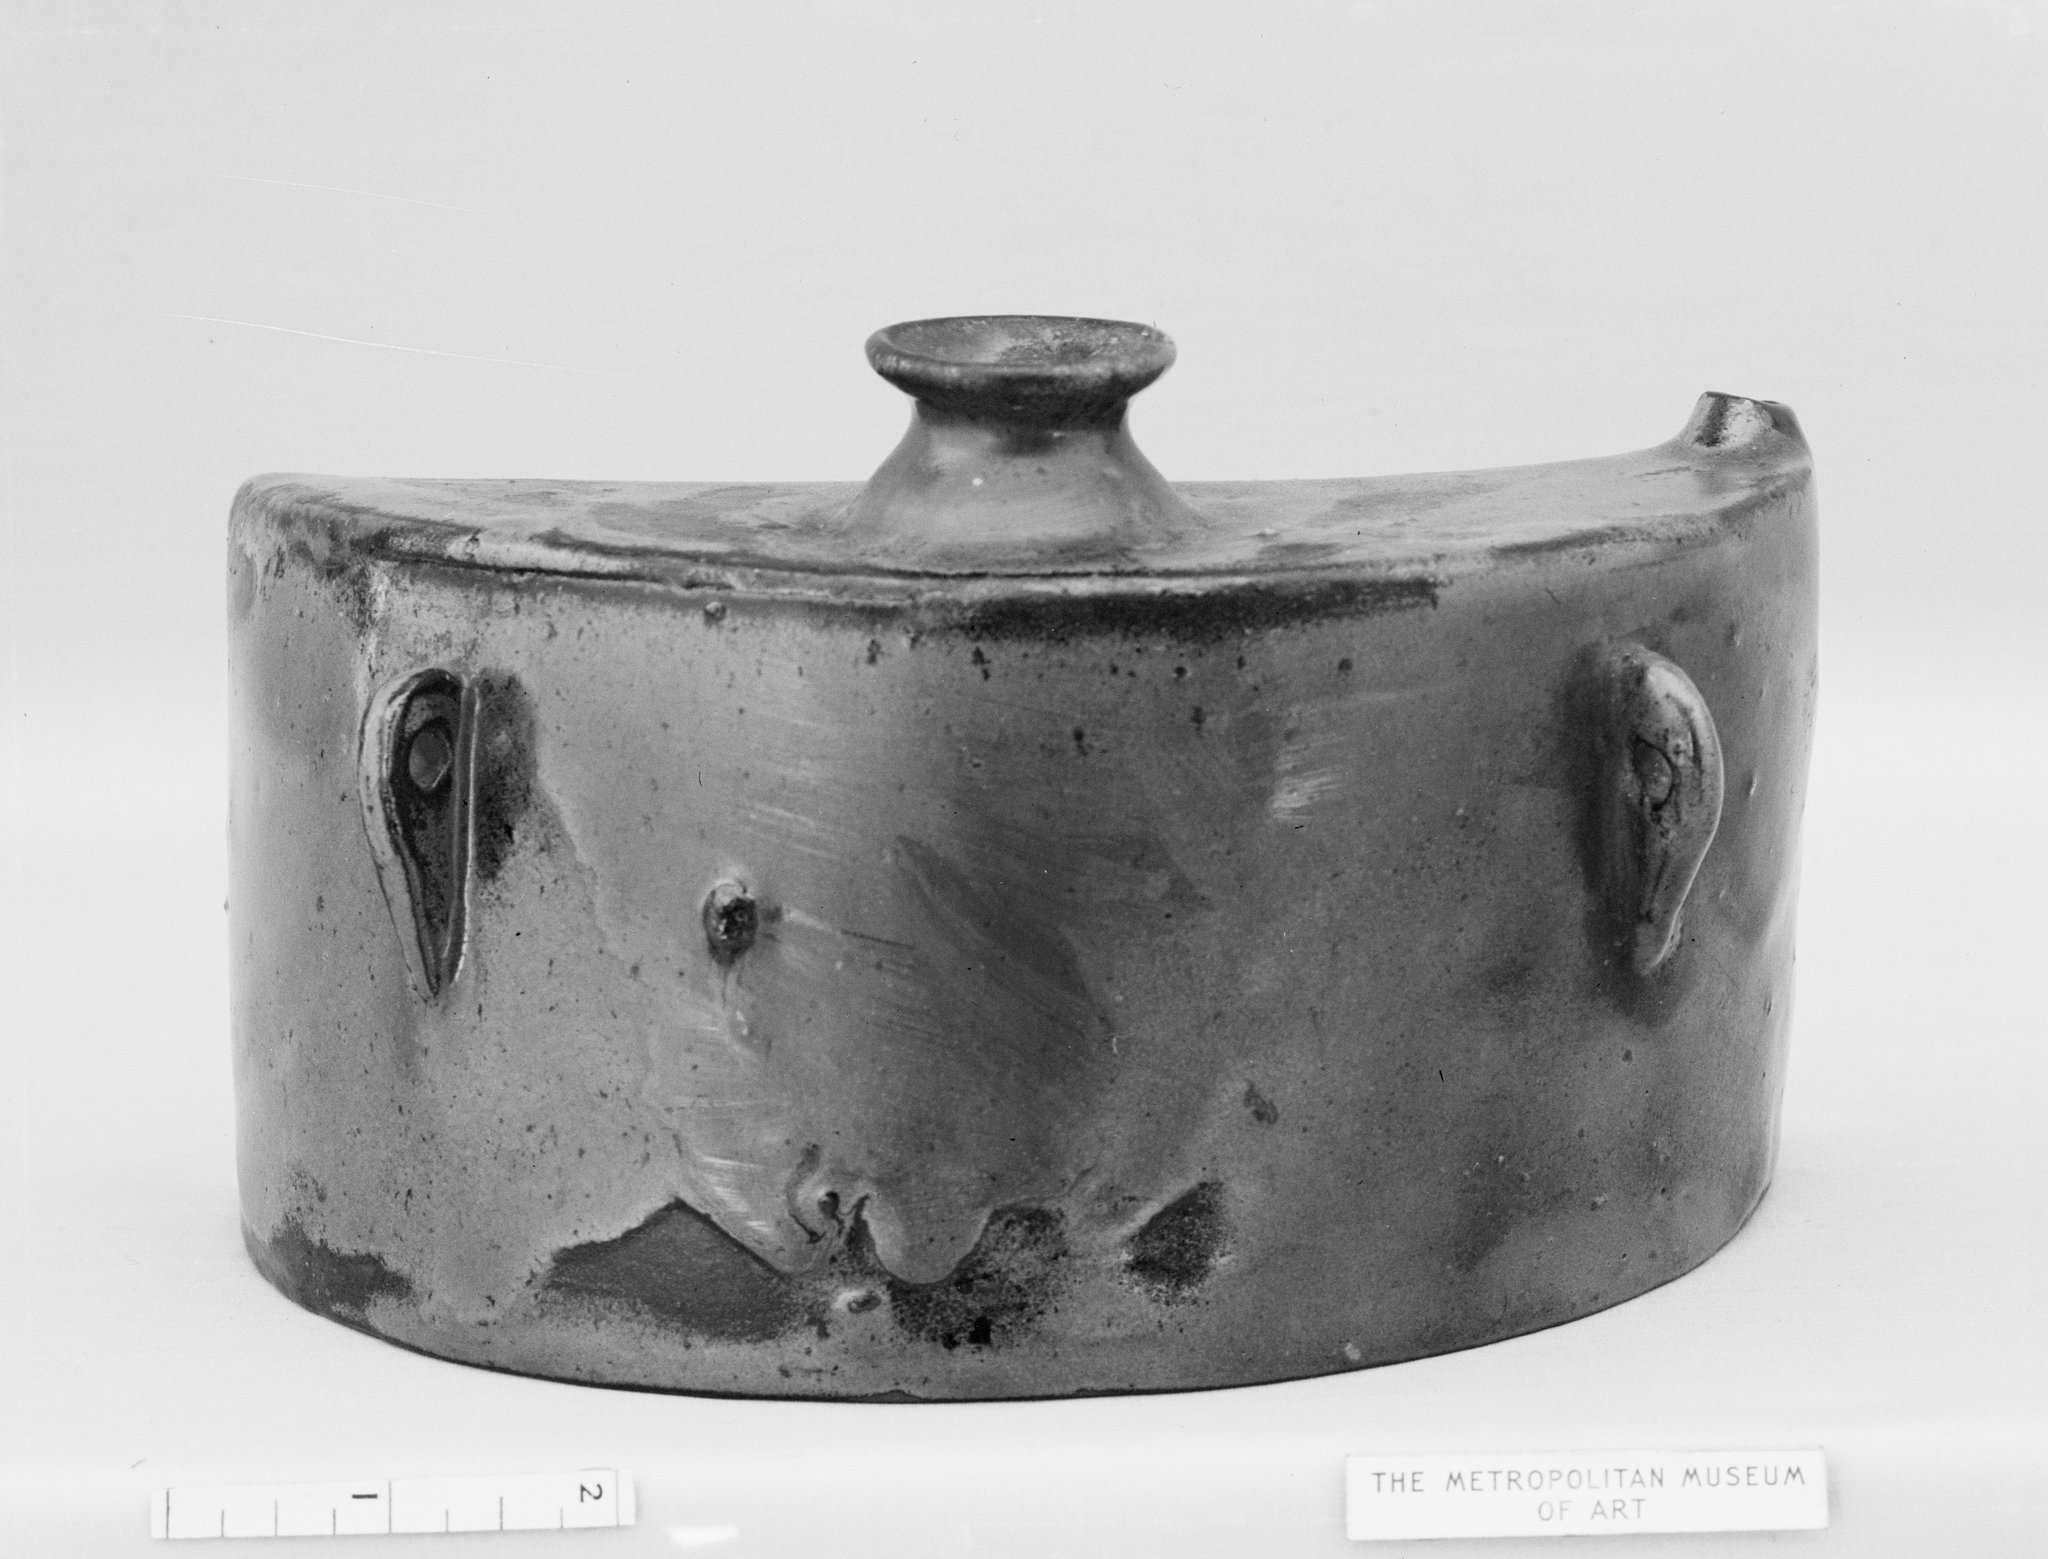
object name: water bottle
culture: japanese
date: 1701-1800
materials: glaze, paste